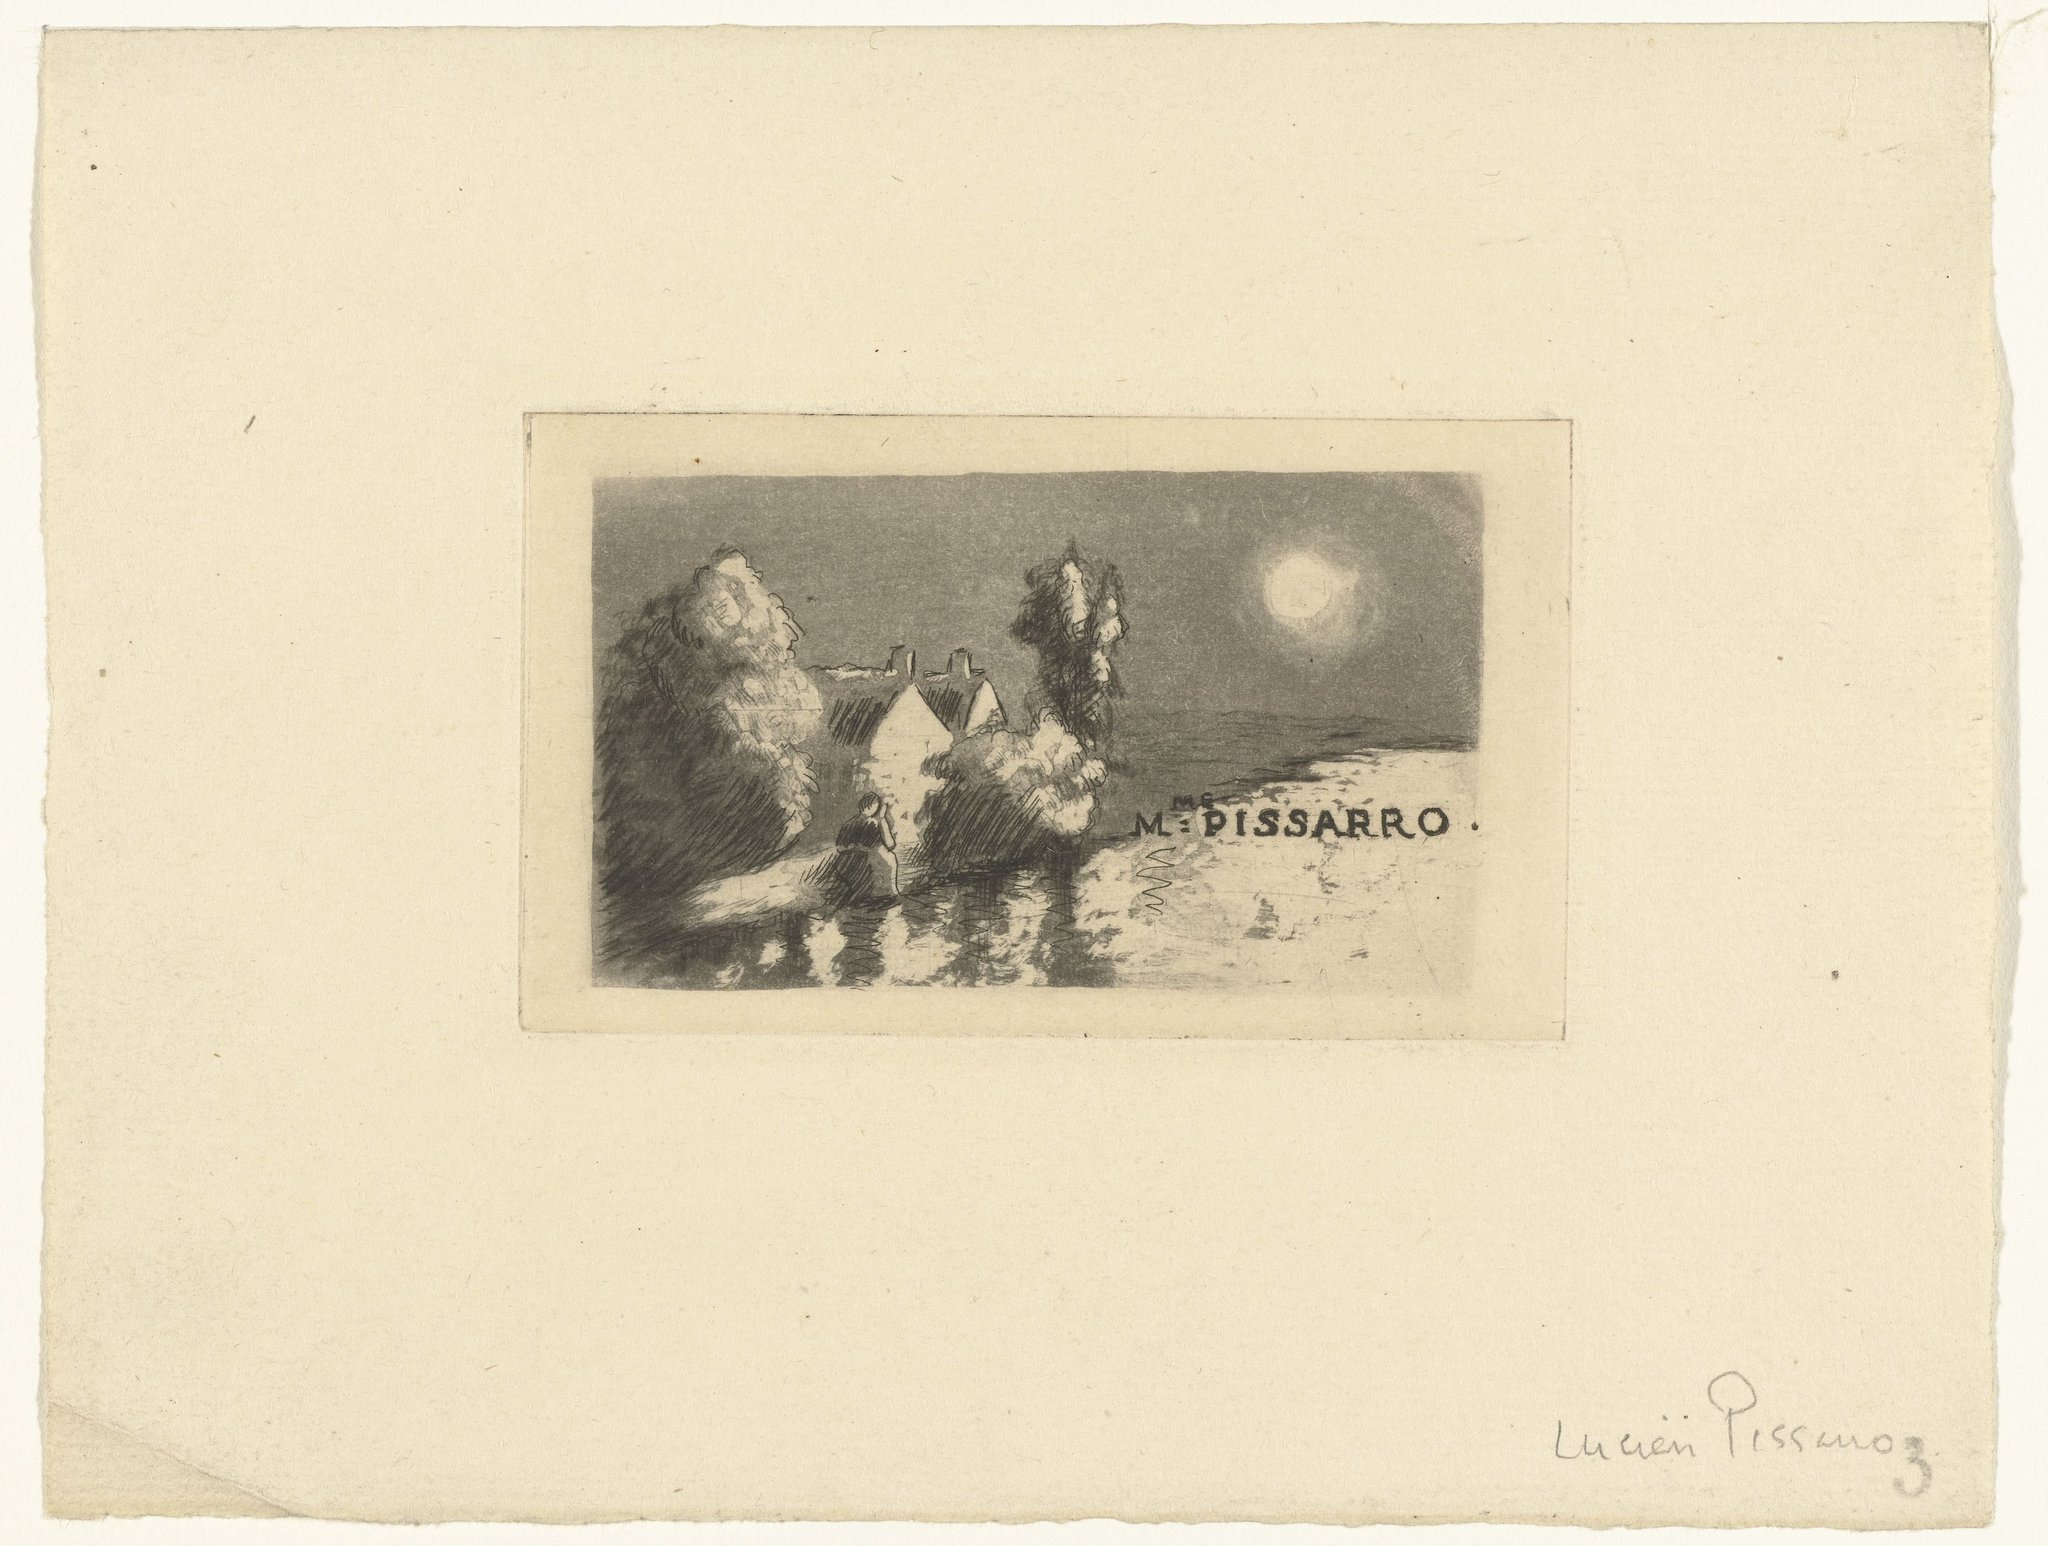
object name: print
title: Visite-kaartje voor Madame Pissarro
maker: lucien pissarro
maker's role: painter, print maker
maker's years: 1863-1944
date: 1873-1944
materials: paper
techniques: aquatint, etching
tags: print maker, orovida camille pissarro, visiting-card, calling-card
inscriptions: collector's mark: Lugt 2228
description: Ontwerp voor een visitekaartje voor de vrouw van Lucien Pissarro. Landschap met een vrouw bij een huis, rechts de tekst "M.me Pissarro".